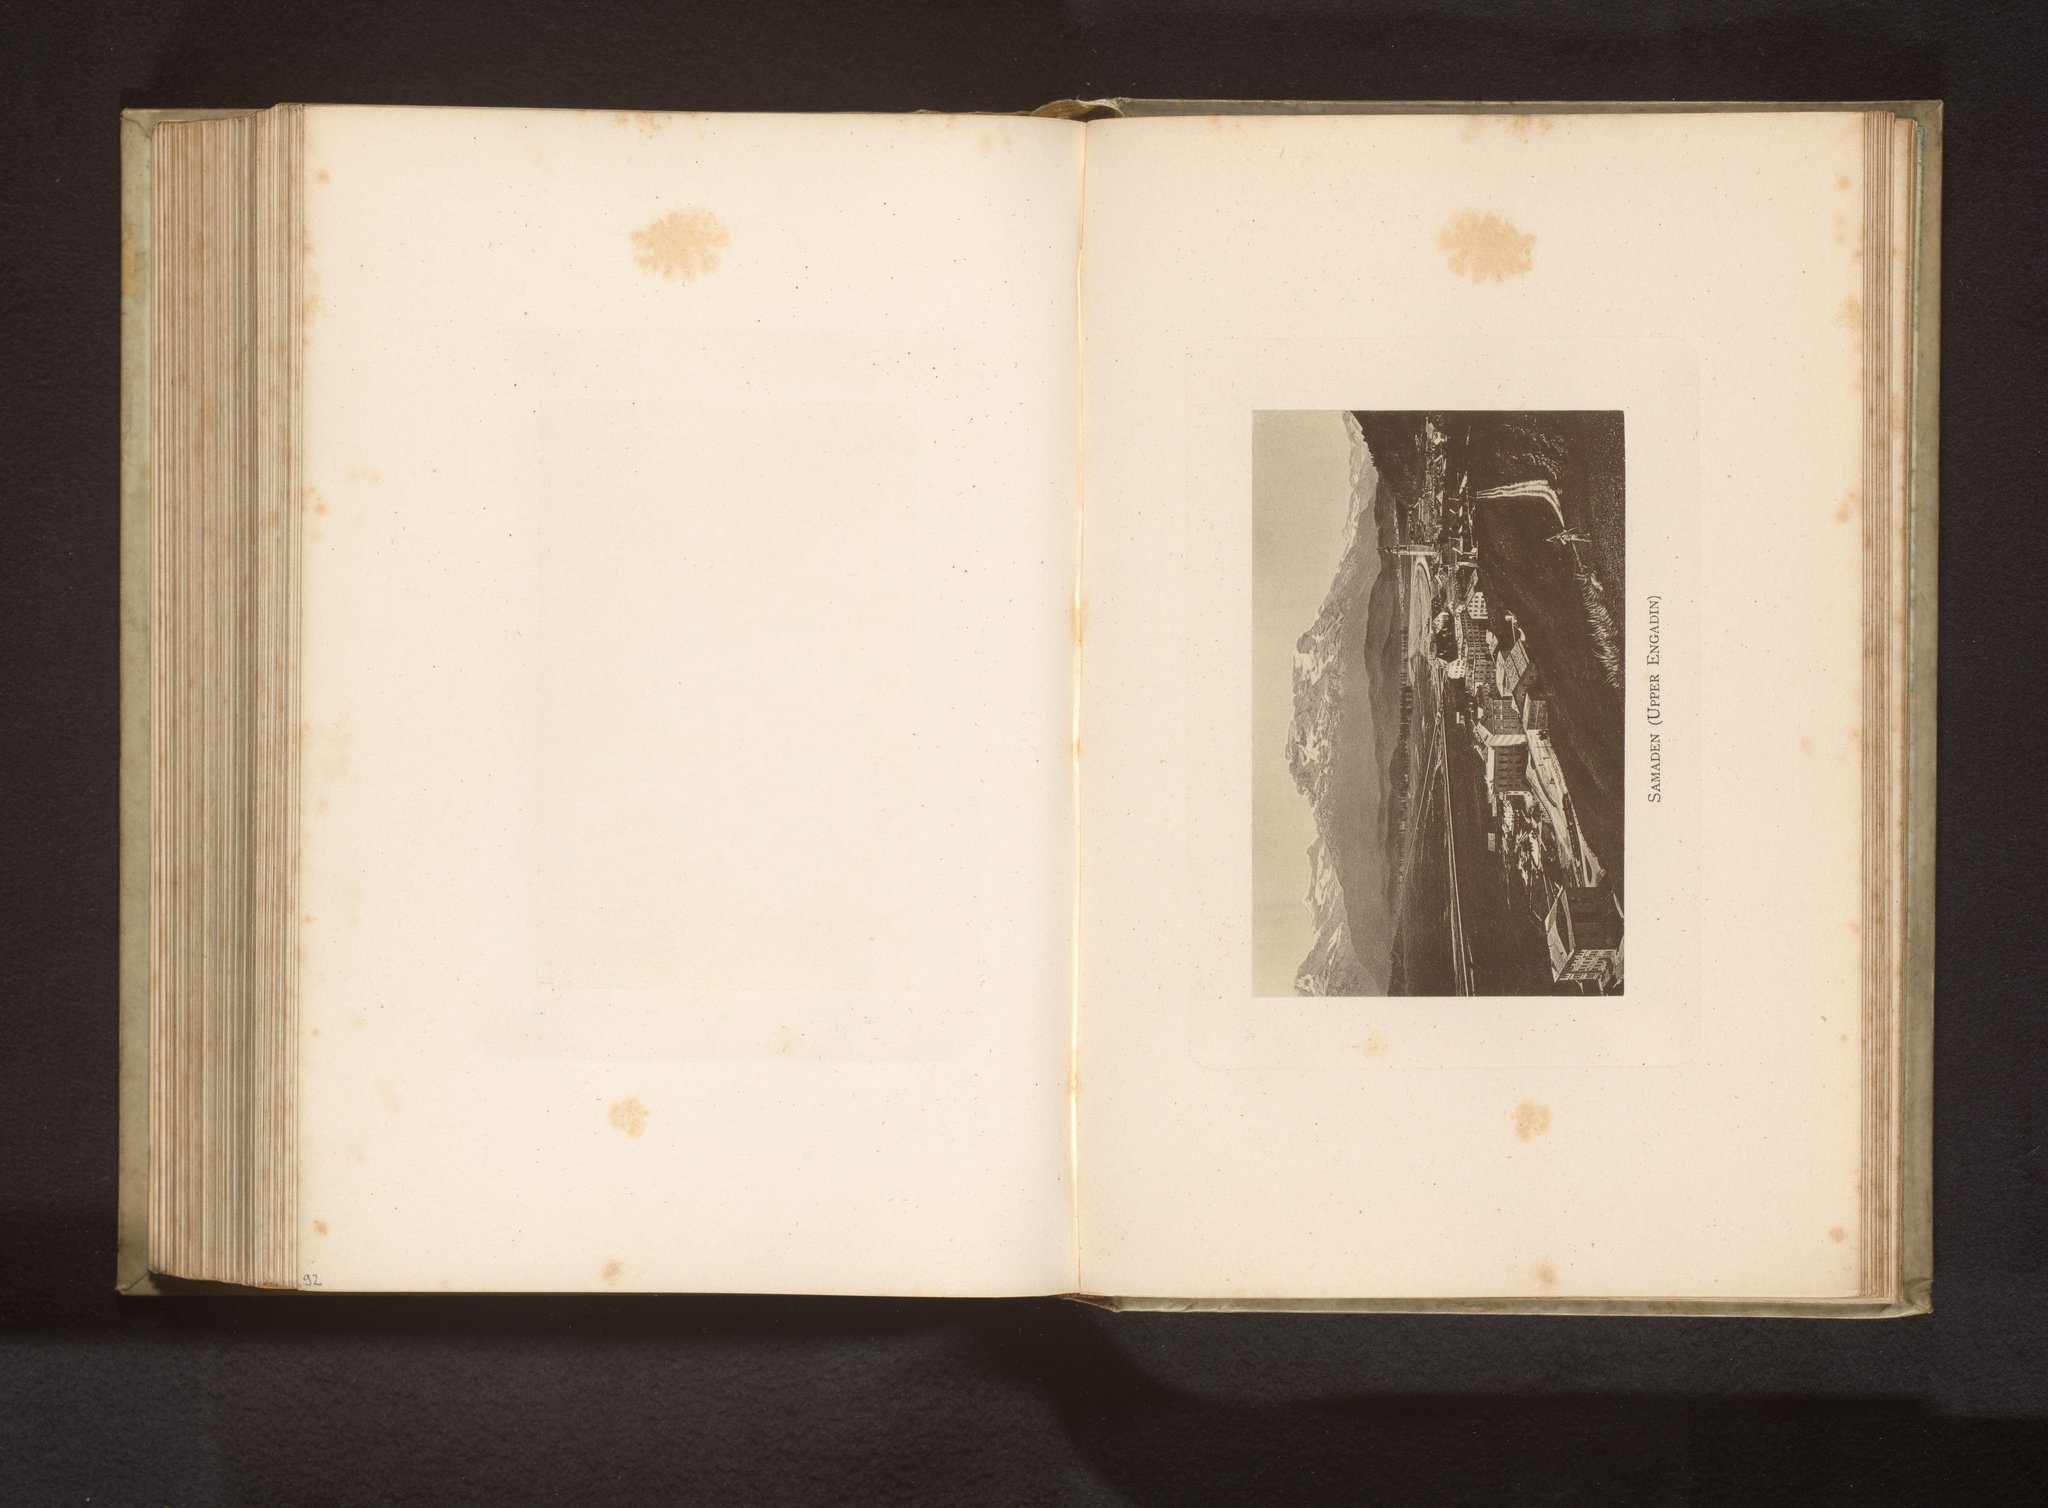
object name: photomechanical print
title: Samaden (Upper Engadin)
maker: Anonymous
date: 1874-1884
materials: paper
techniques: photograph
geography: graubunden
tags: city-view, and landscape with man-made constructions, mountains